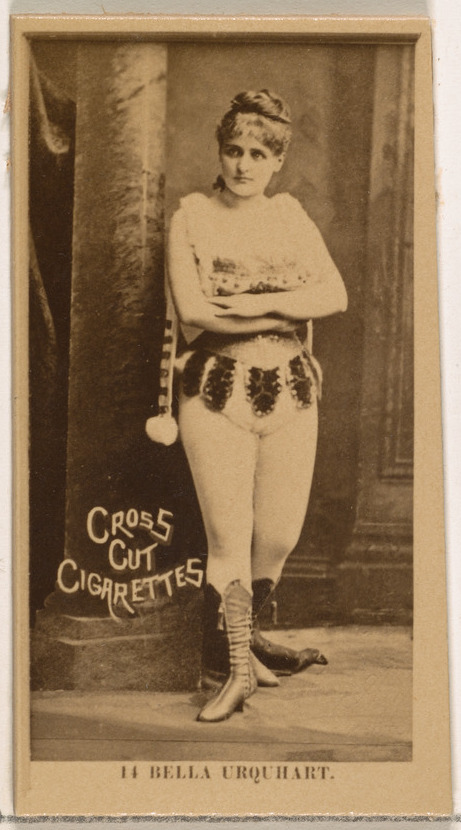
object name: print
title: Card Number 44, Bella Urquhart, from the Actors and Actresses series (N145-2) issued by Duke Sons & Co. to promote Cross Cut Cigarettes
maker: w. duke, sons & co.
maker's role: publisher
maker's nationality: american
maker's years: 1870-1920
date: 1880-1889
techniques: albumen silver print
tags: portraits,women,actresses